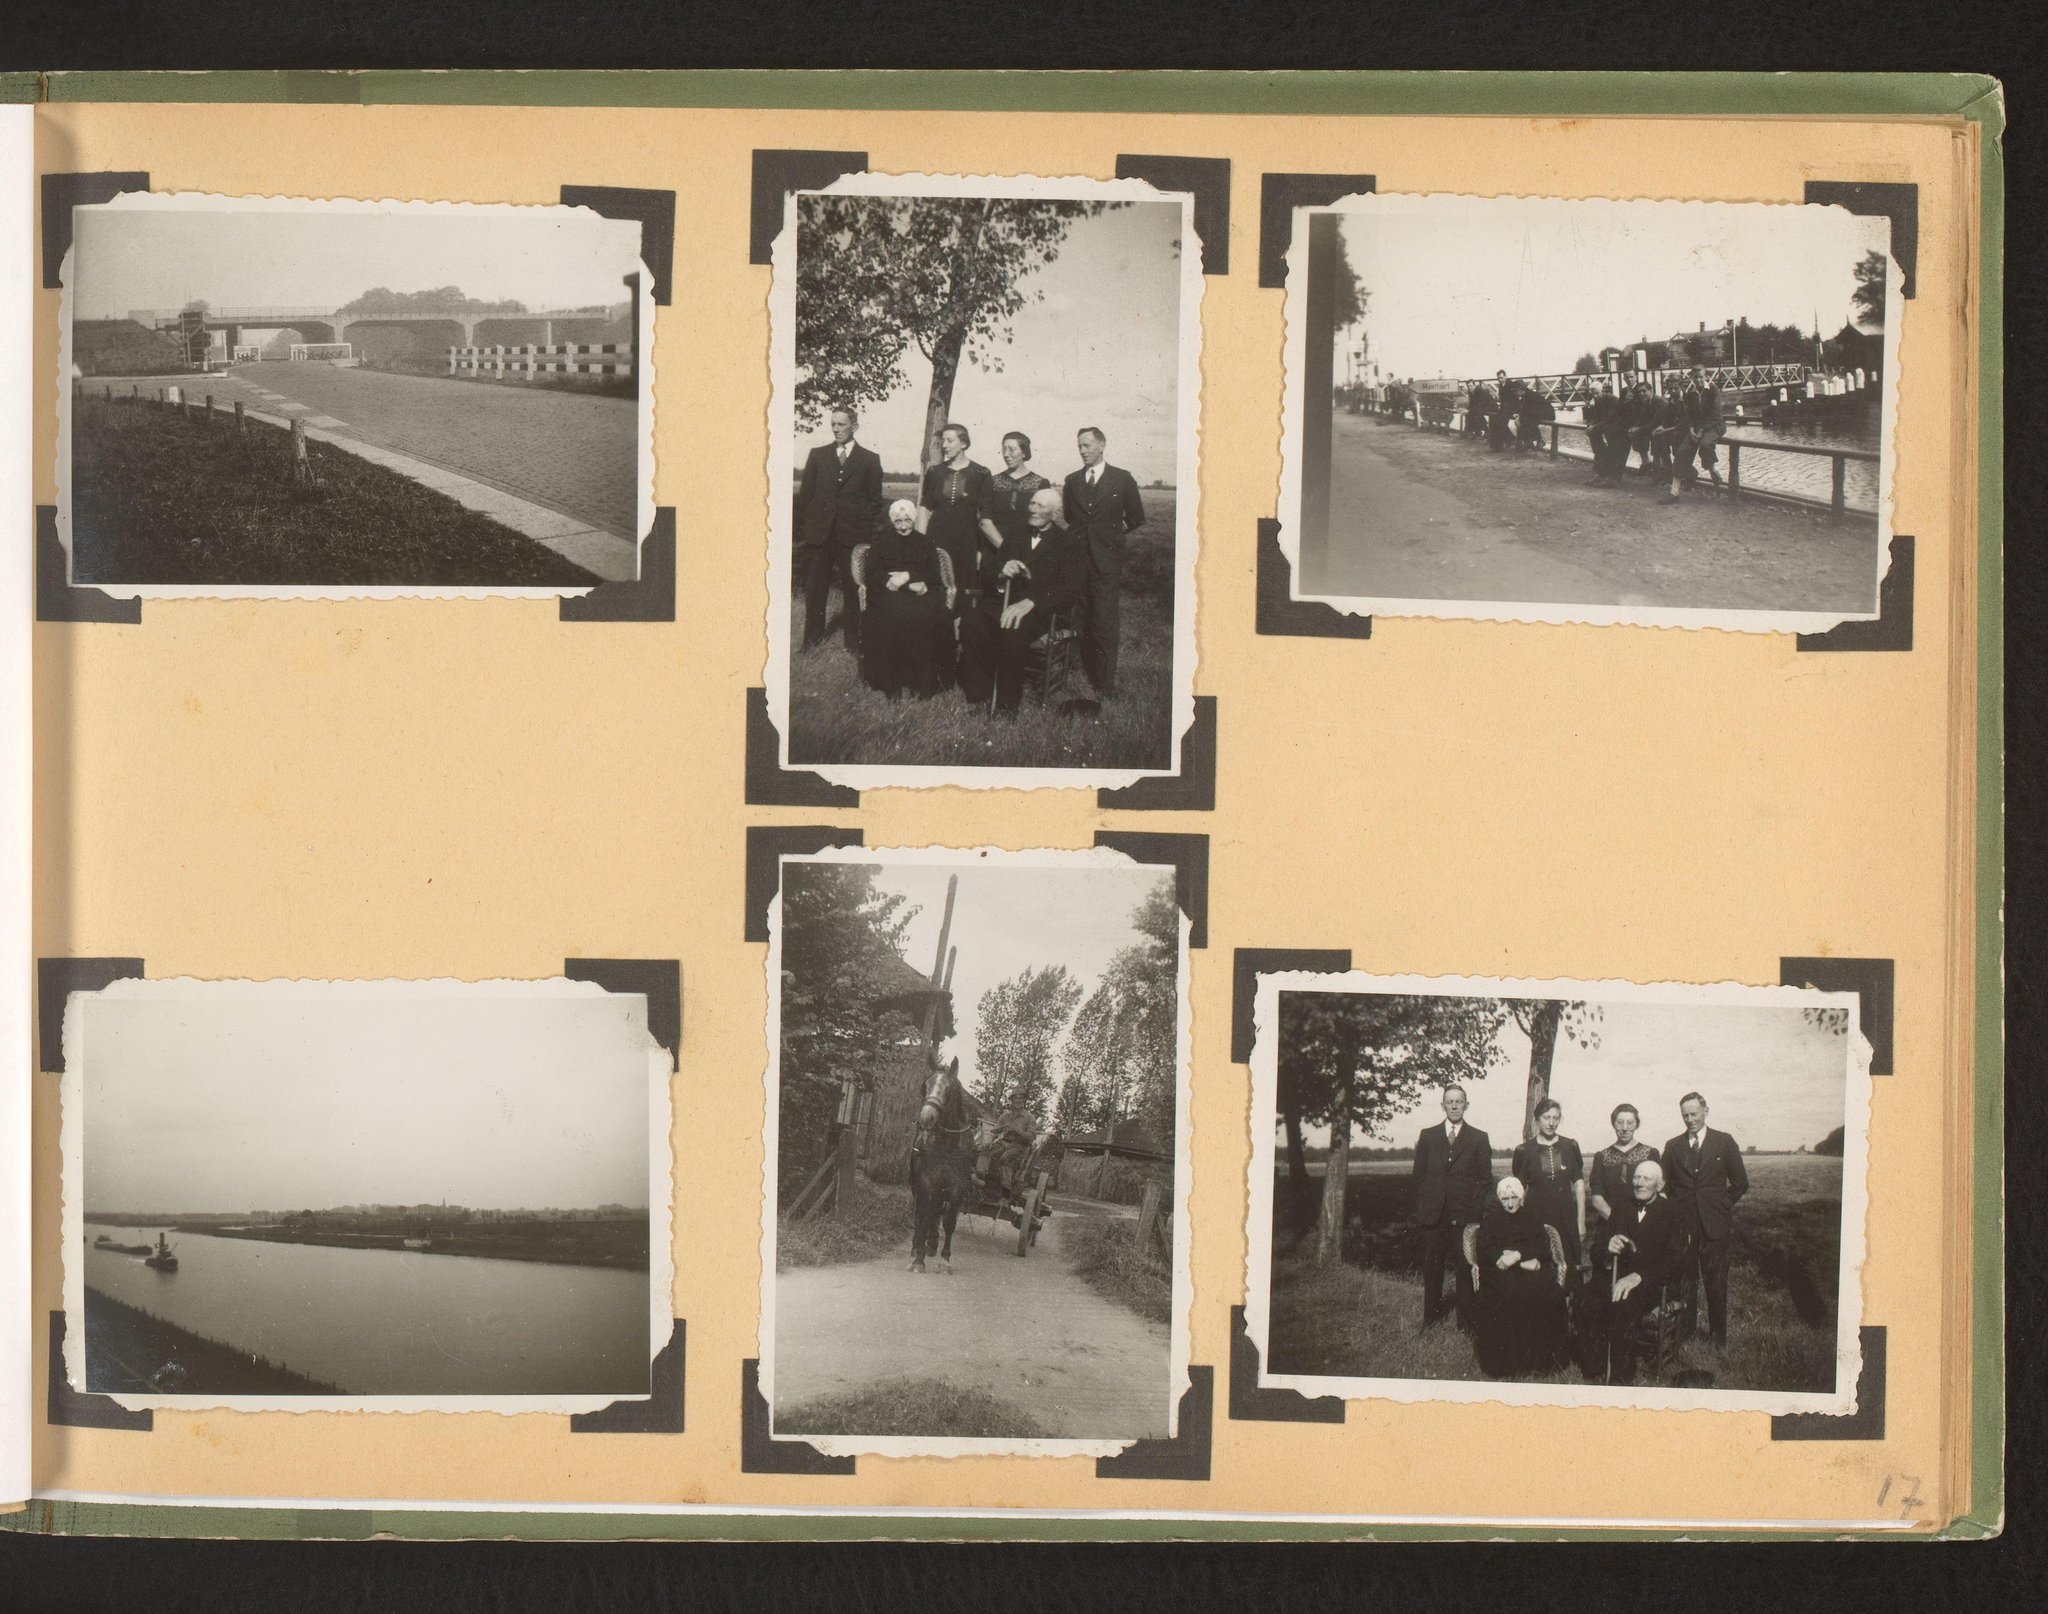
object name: photograph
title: Omgeving en familie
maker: Anonymous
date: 1940-1944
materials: paper, photographic support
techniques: gelatin silver print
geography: netherlands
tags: farmers, farm (building), netherlands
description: Albumblad met zes foto´s van een familie en van landschap en bebouwing in de omgeving (Montfoort). Onderdeel van het fotoalbum Bewaking bunkers.